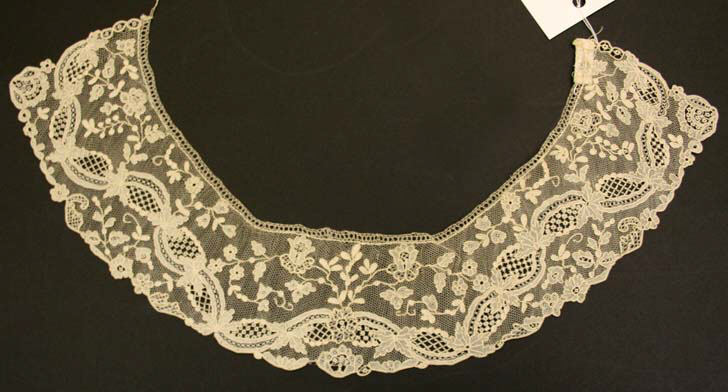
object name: collar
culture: french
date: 1801-1900